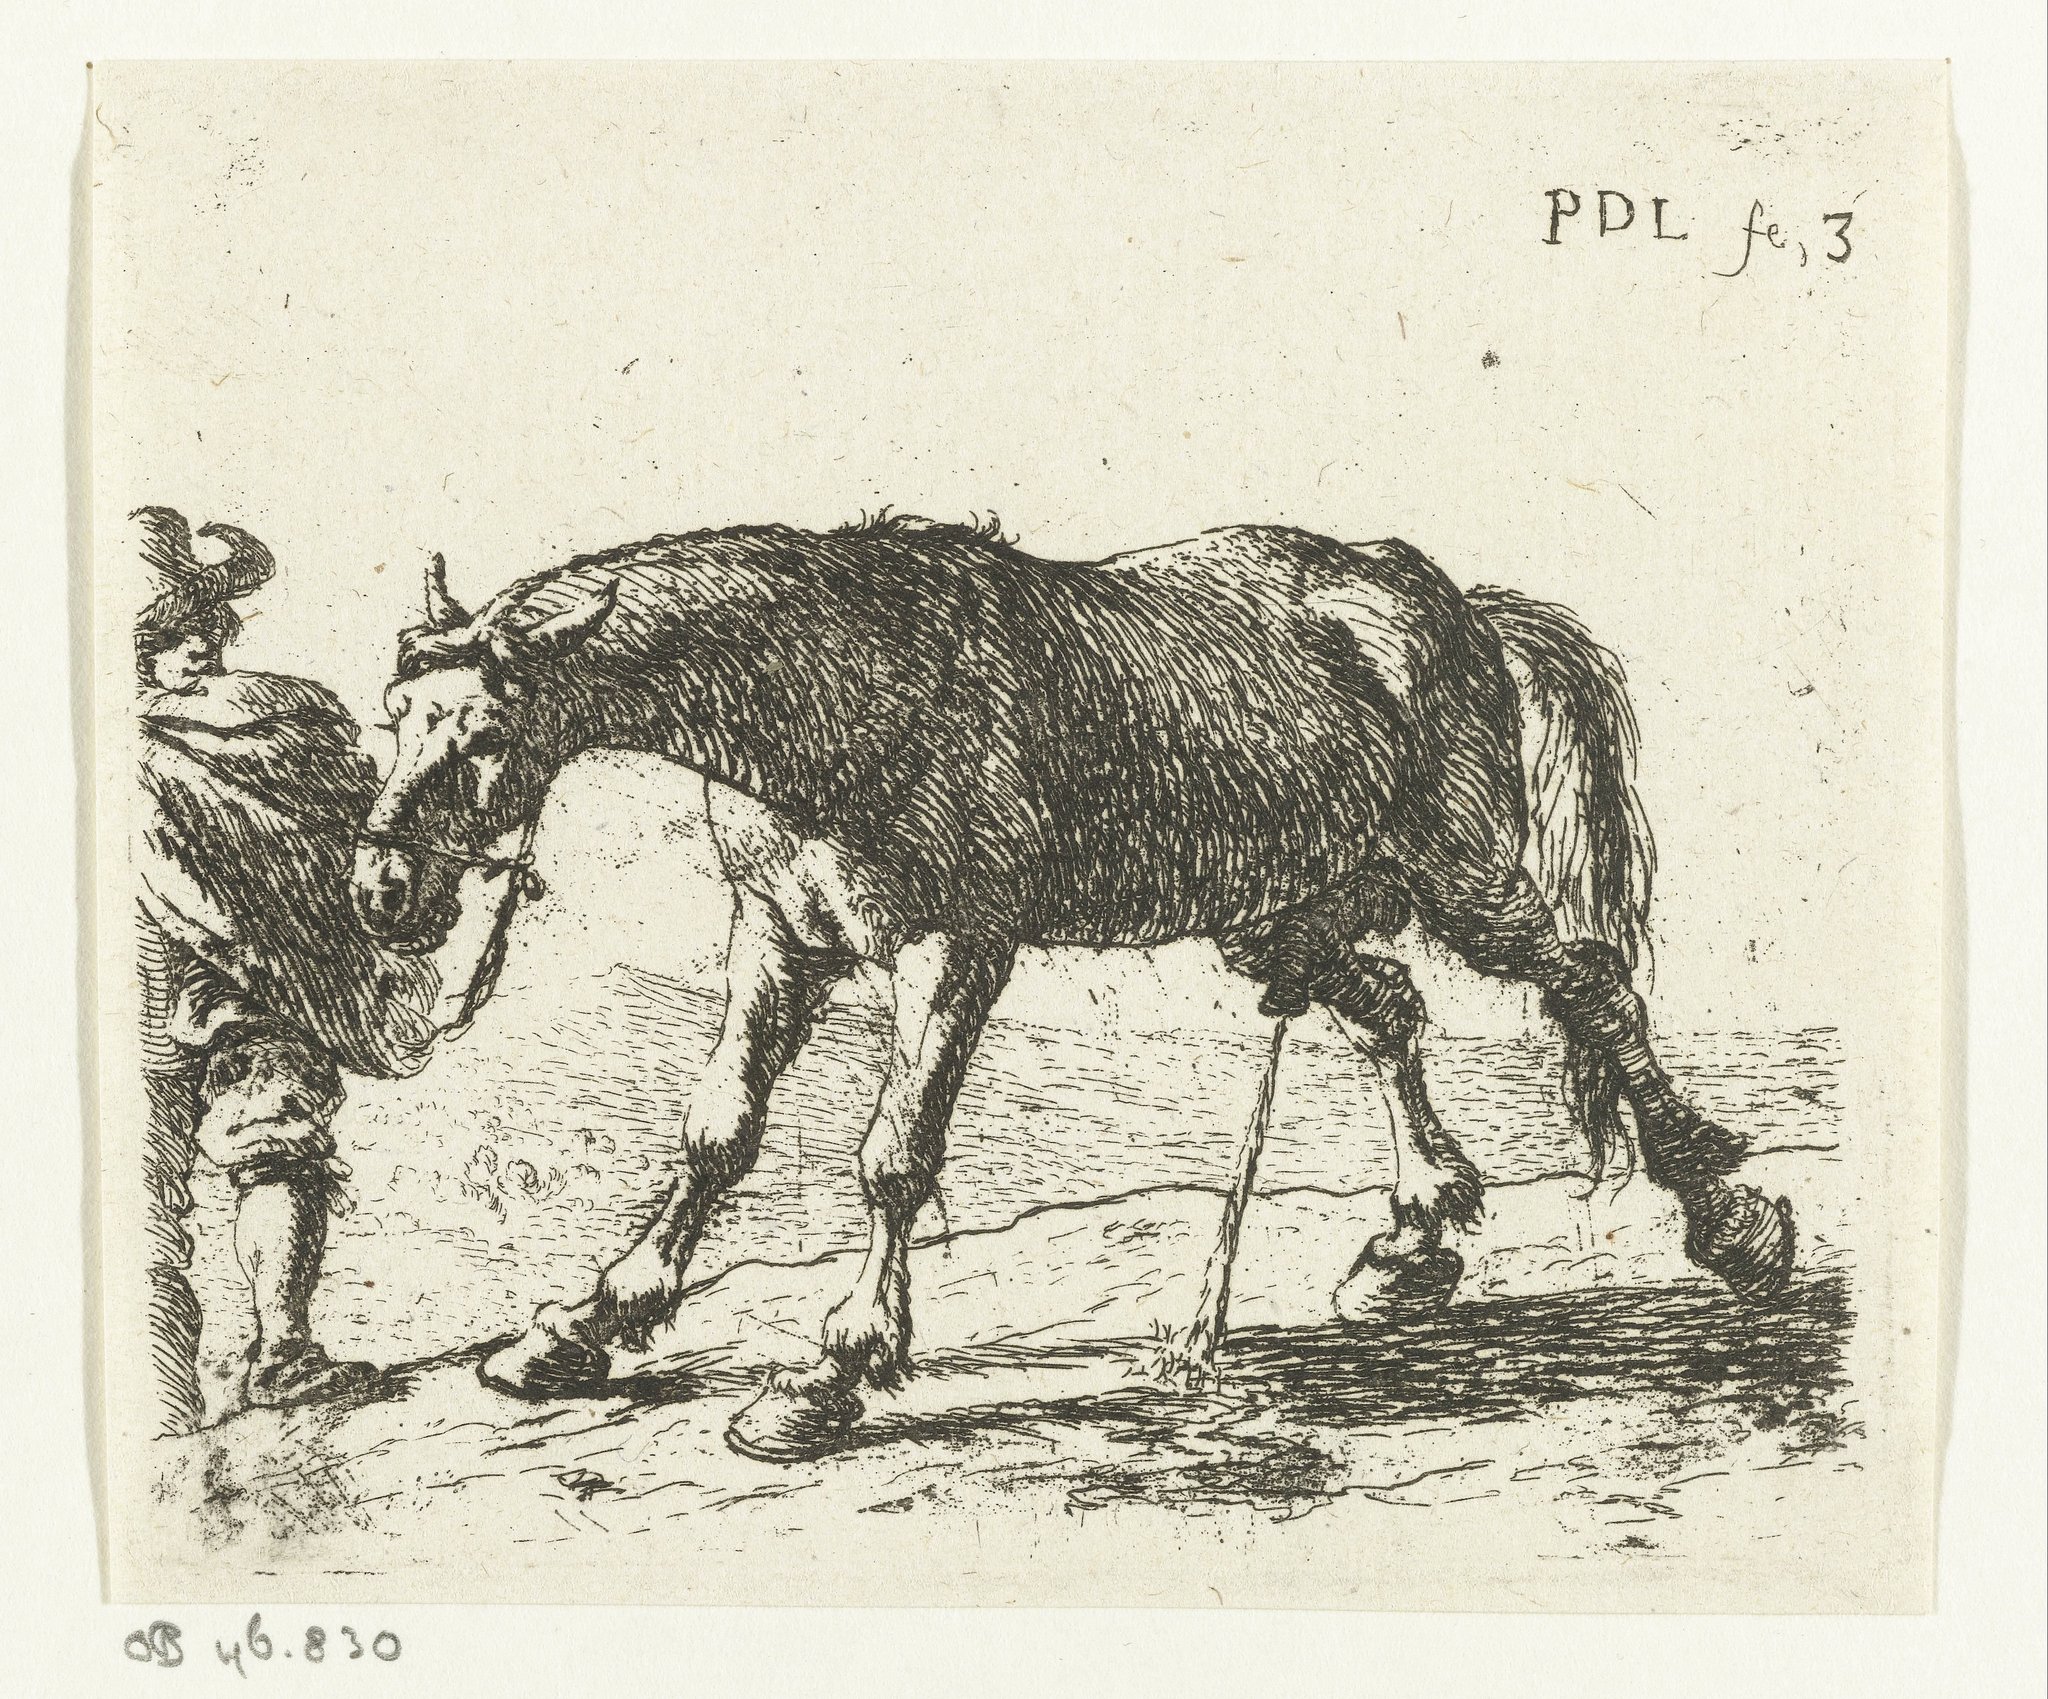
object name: print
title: Paarden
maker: pieter bodding van laer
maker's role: draughtsman, painter, print maker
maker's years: 1599-1642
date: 1609-1642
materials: paper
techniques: etching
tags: horse, urination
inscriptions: collector's mark: Lugt 2228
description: Een pissend paard, links staat een man met de teugels in zijn handen. De prent maakt deel uit van een zesdelige serie met voorstellingen van paarden.